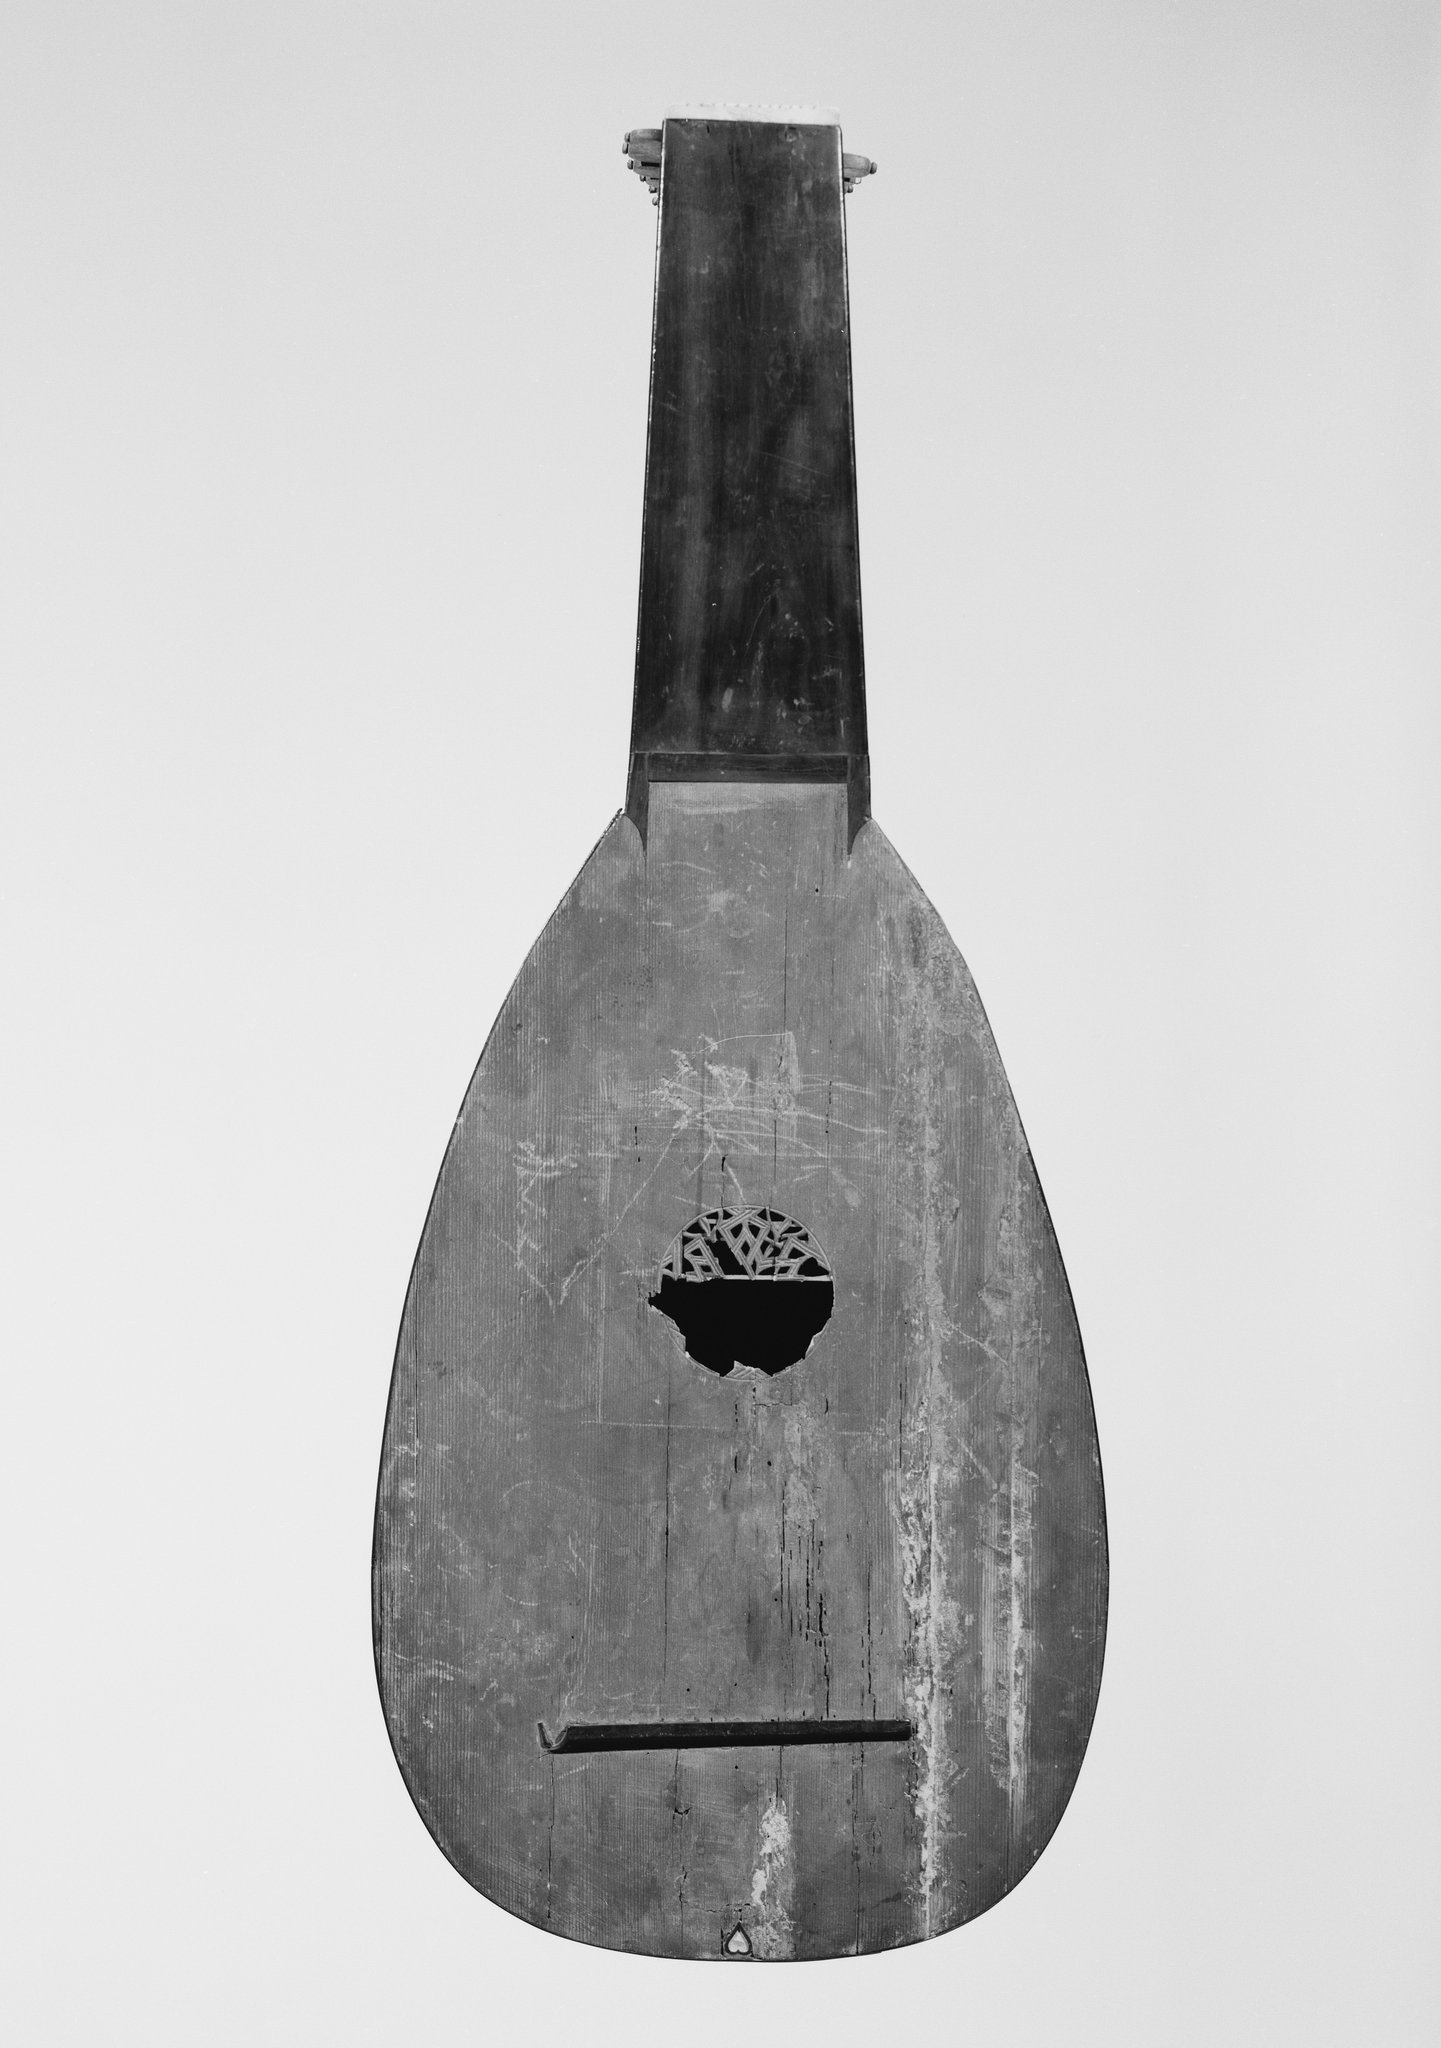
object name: lute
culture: austrian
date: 1534-1566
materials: wood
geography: austria